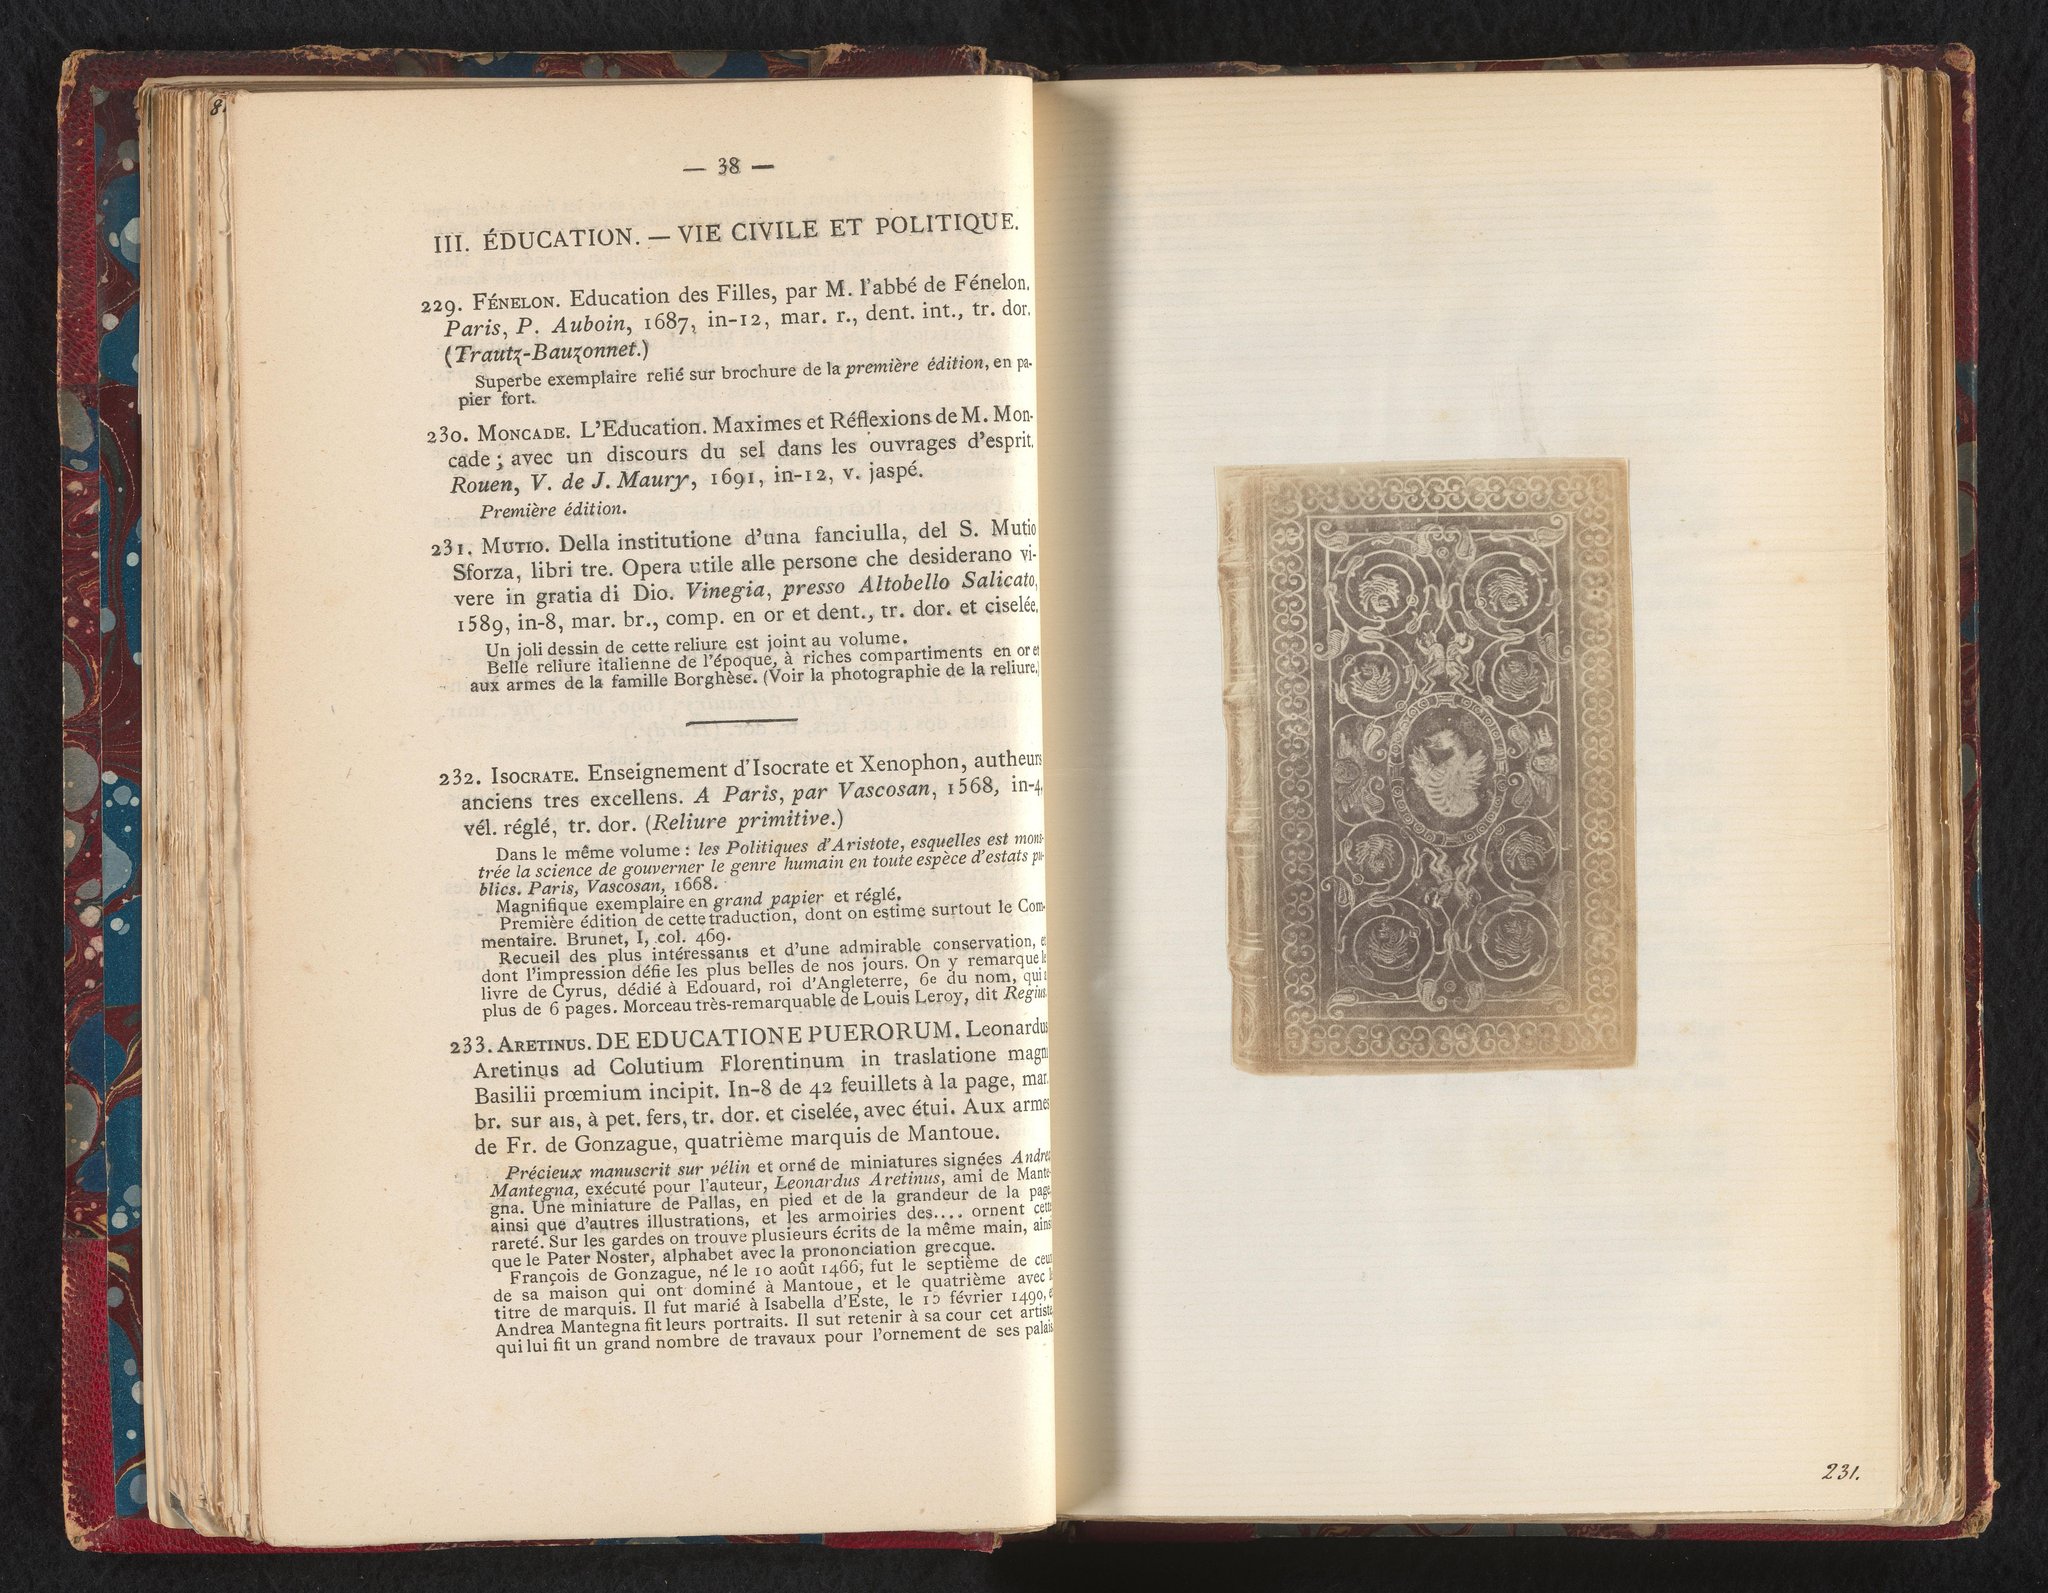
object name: page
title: Fotoreproductie van boekomslag van Mutio uit 1589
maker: Anonymous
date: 1863-1868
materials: paper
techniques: albumen print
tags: book-cover, binding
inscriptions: number: ‘231’